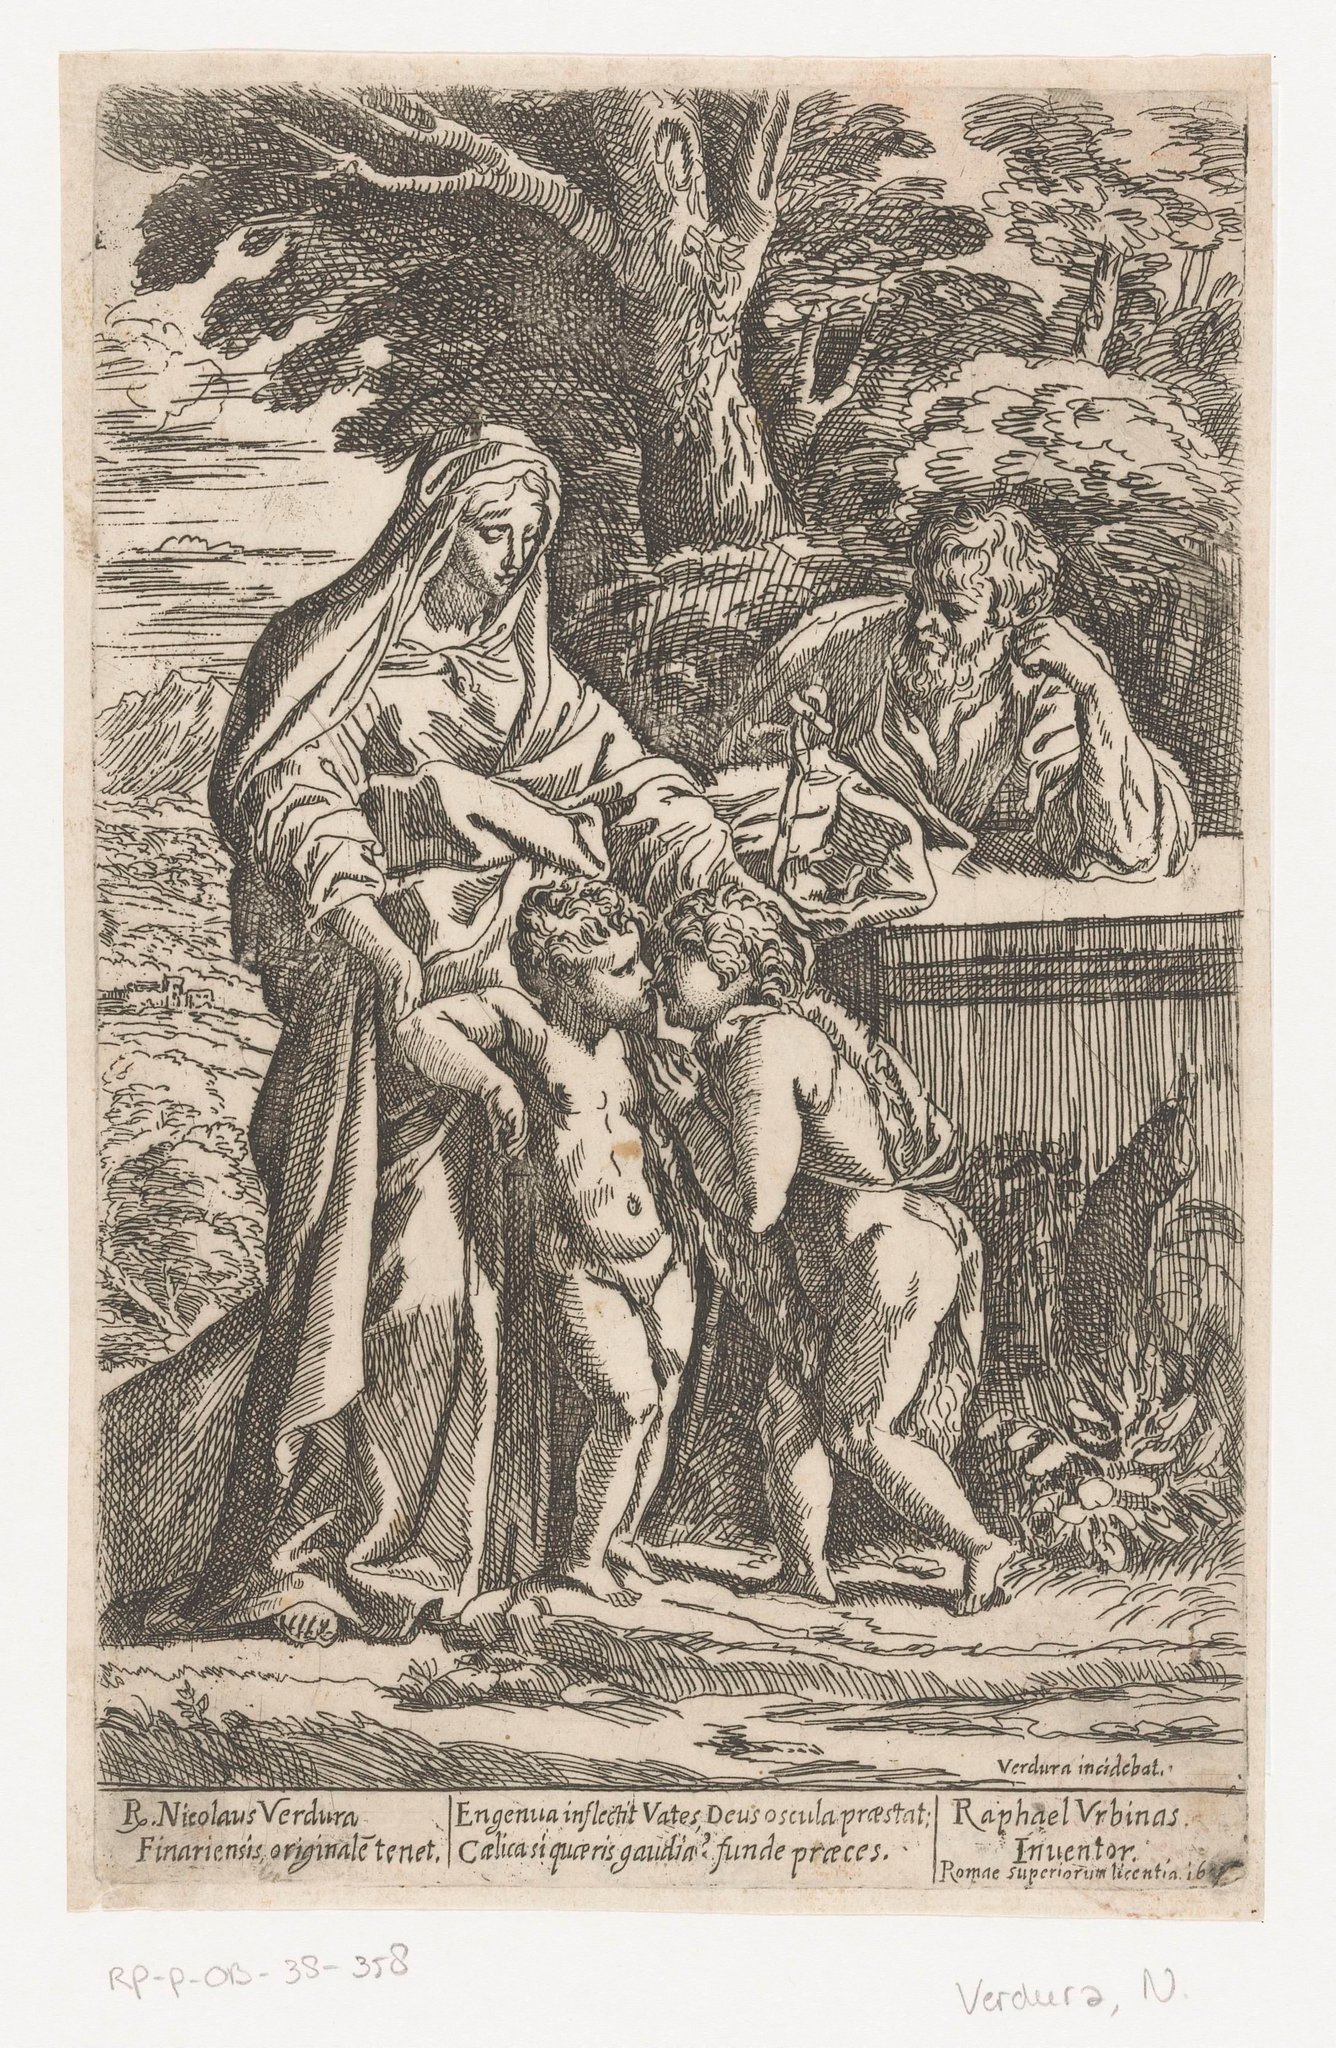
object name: print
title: Heilige Familie met Johannes de Doper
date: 1632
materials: paper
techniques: etching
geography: vatican city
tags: holy family with john the baptist (as child)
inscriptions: collector's mark: Lugt 240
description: Maria en Jozef in een landschap. Voor Maria staan Christus en de jonge Johannes de Doper. Latijnse tekst in twee kolommen in ondermarge.